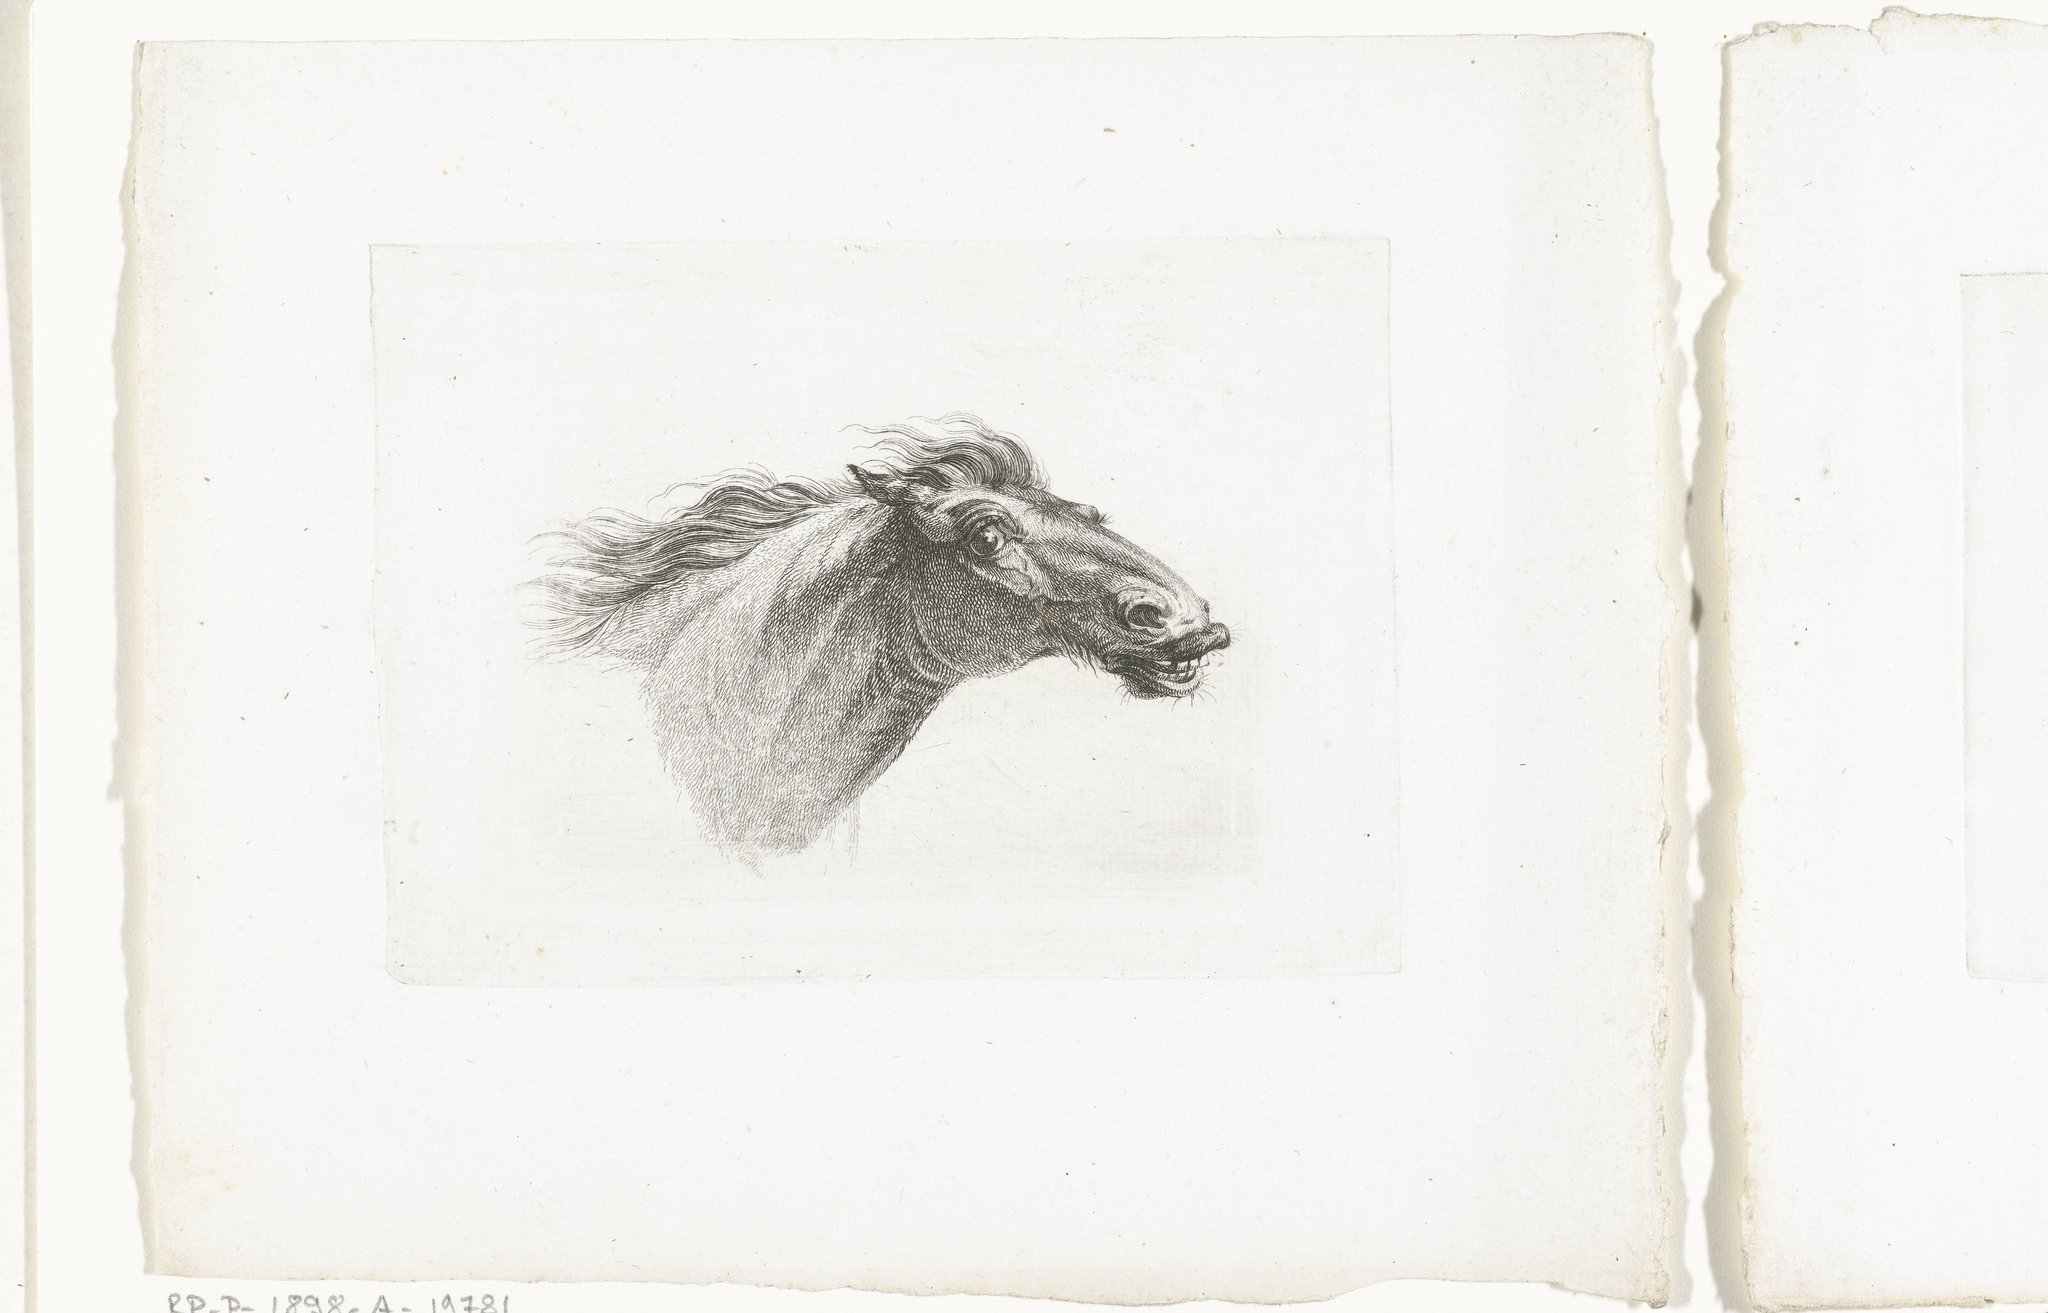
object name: print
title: Paardenhoofden naar Gerrit Malleyn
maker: joannes bemme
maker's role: print maker, printer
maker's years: 1775-1841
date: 1801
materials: paper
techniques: etching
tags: horse (+ head of an animal)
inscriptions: collector's mark: Lugt 2228